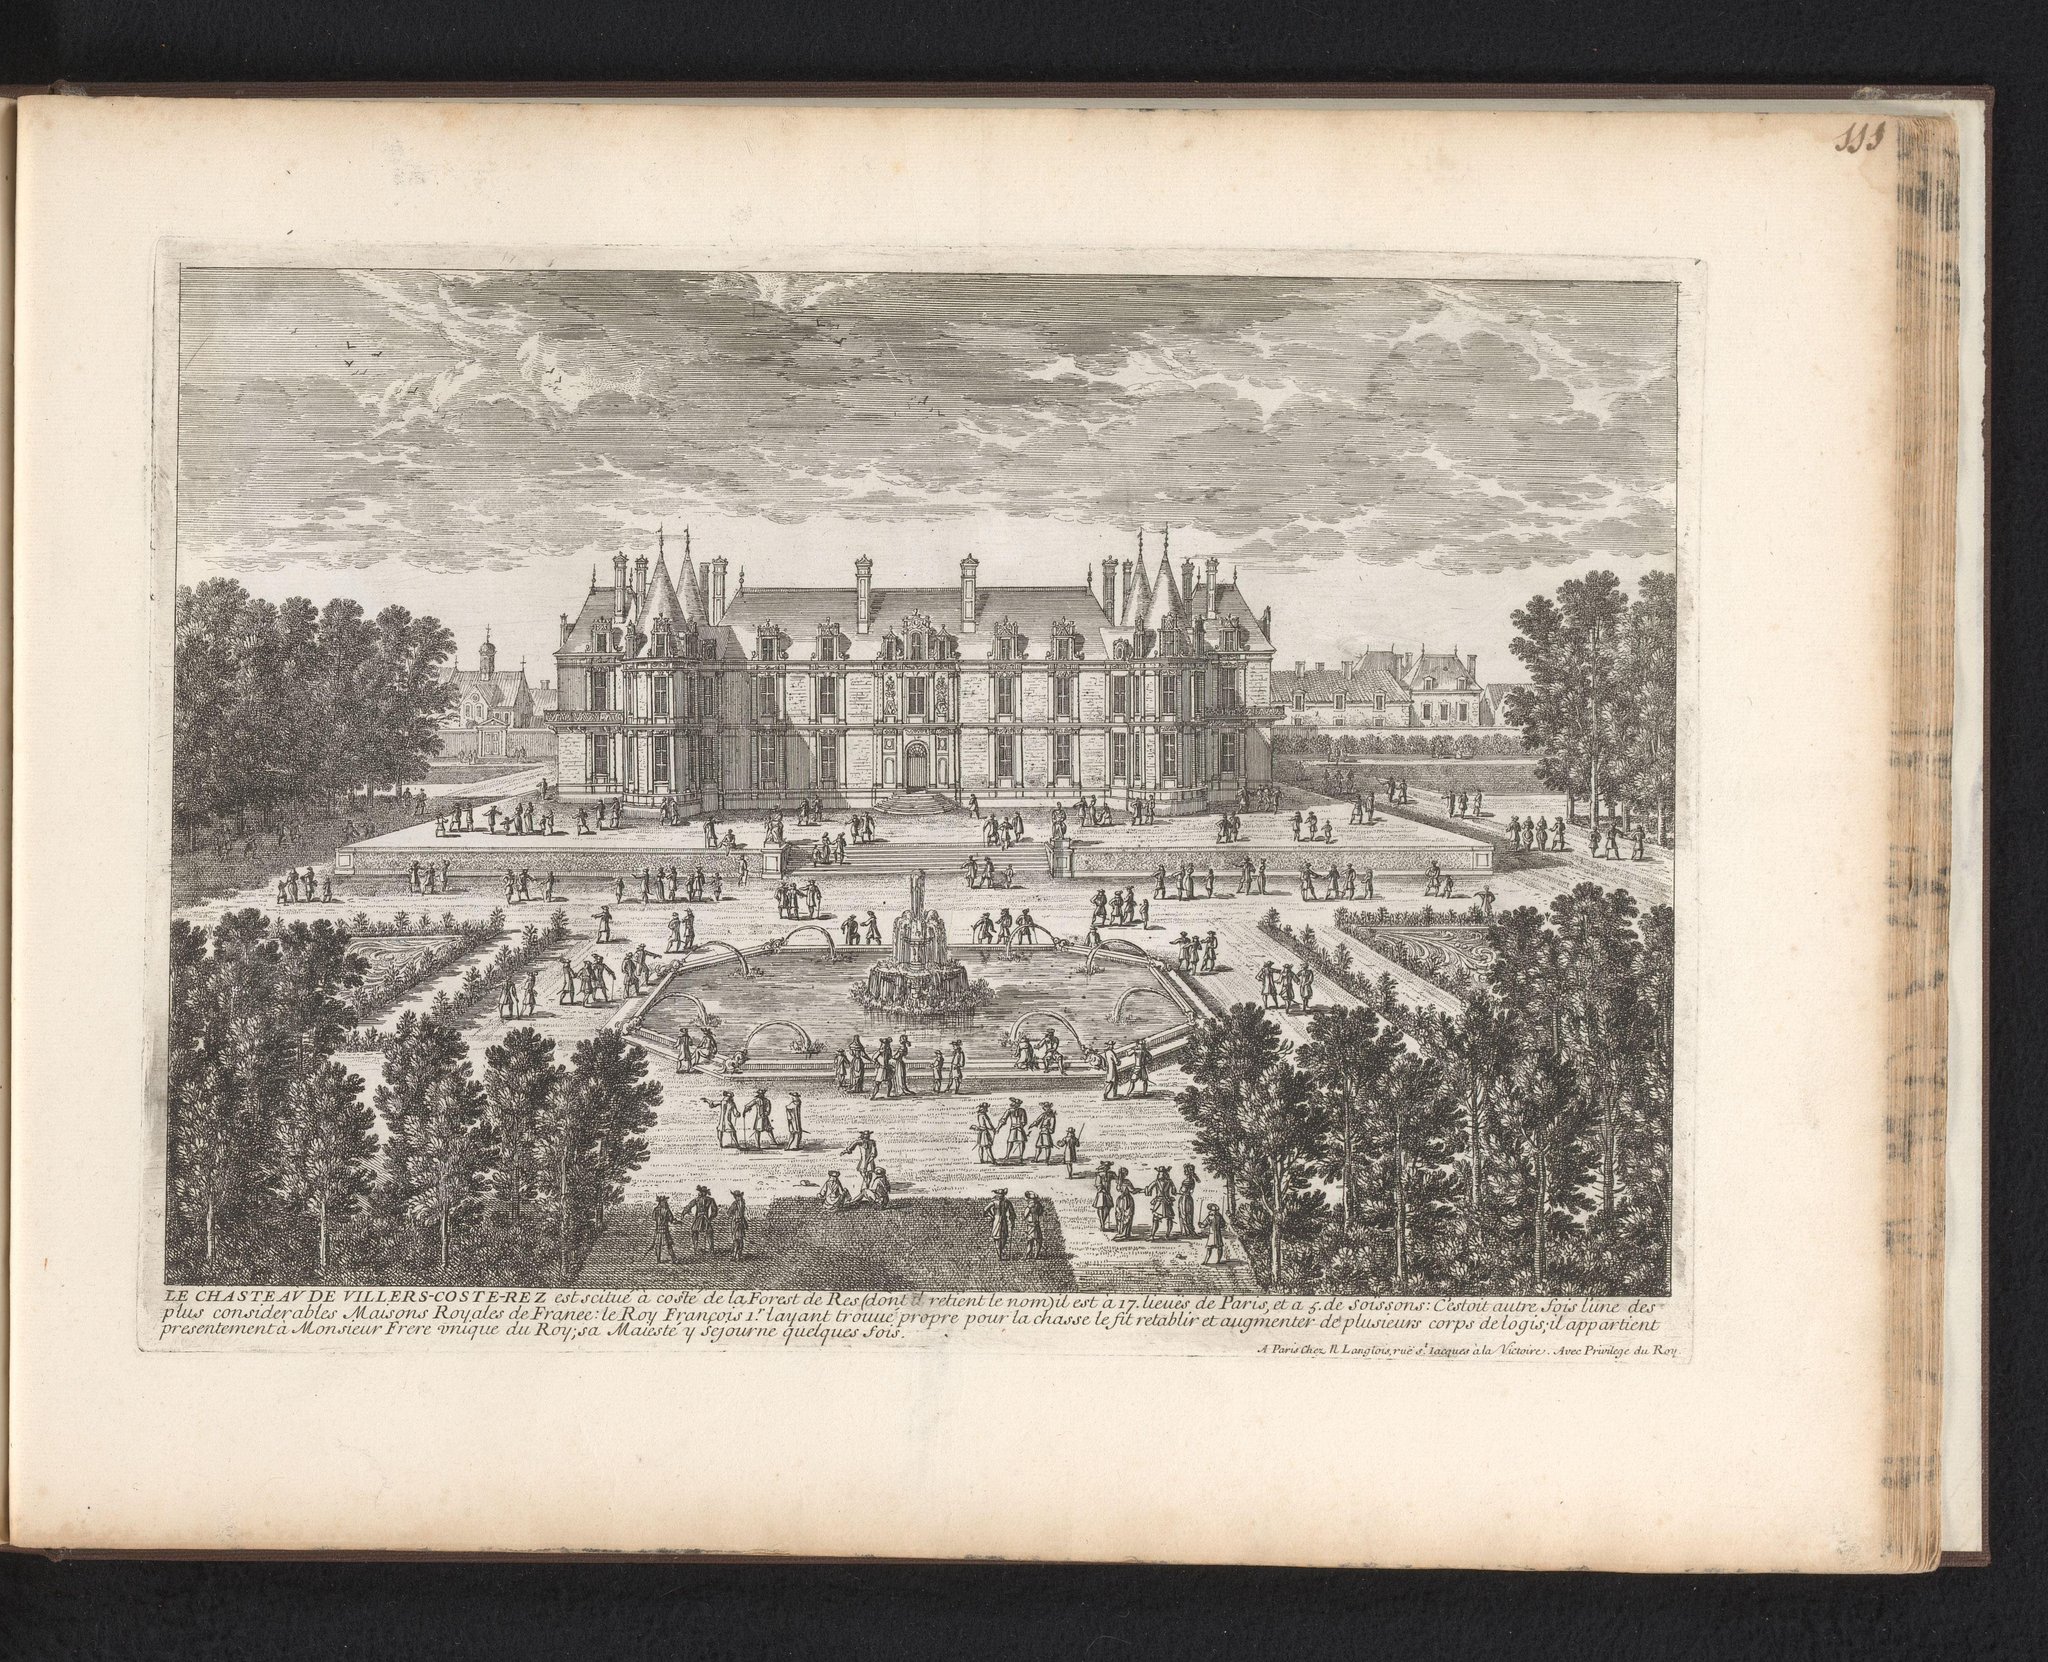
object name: print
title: Recueil de vues de monuments de Paris, des principales résidences royales et des principaux châteaux de France et de Rome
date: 1660-1703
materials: paper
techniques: etching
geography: france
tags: garden fountain, french or architectonic garden; formal garden, landscape with tower or castle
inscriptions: collector's mark: Lugt 2228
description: Prenten met het signatuur 'Perelle' kunnen zowel door vader Gabriel als door zonen Nicolas en Adam gemaakt zijn. De uitgevers vader en zoon Nicolas Langlois worden allebei vermeld als N. Langlois op hetzelfde adres.